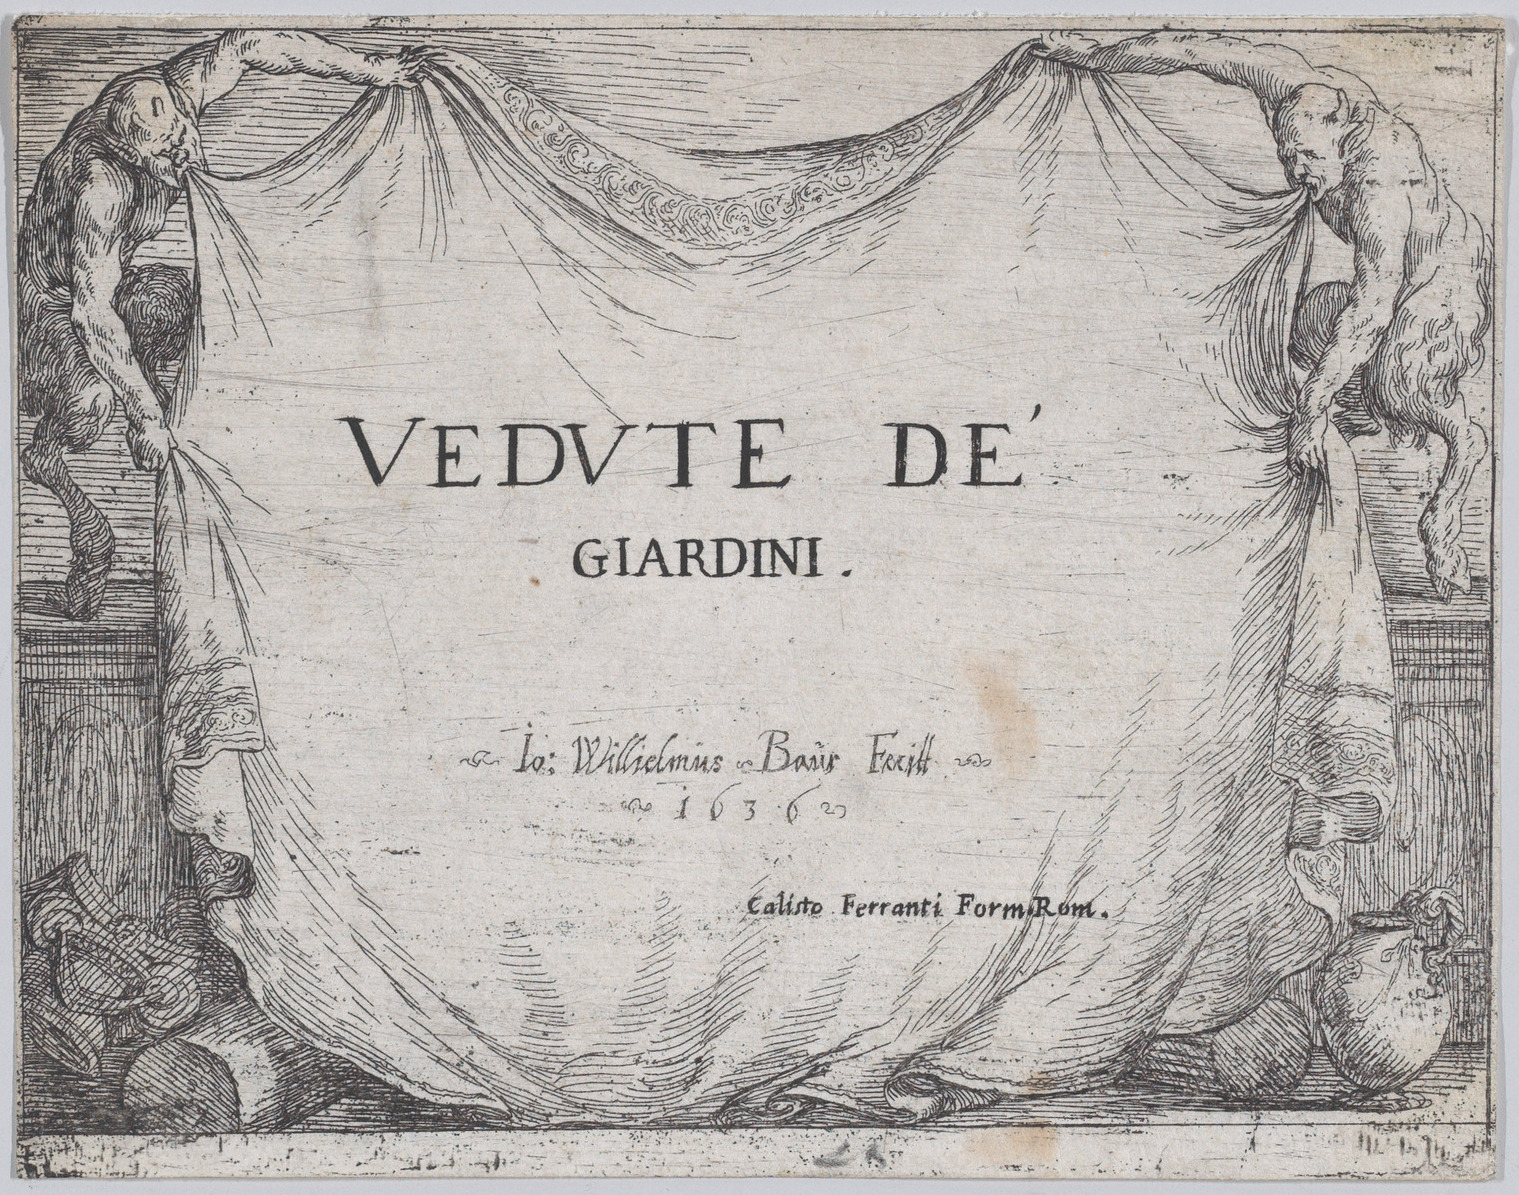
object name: print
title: Title page of 'Views of Gardens' (Vedute de' Giardini)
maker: johann wilhelm baur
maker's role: artist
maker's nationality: german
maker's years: 1607-1642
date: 1636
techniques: etching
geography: rome